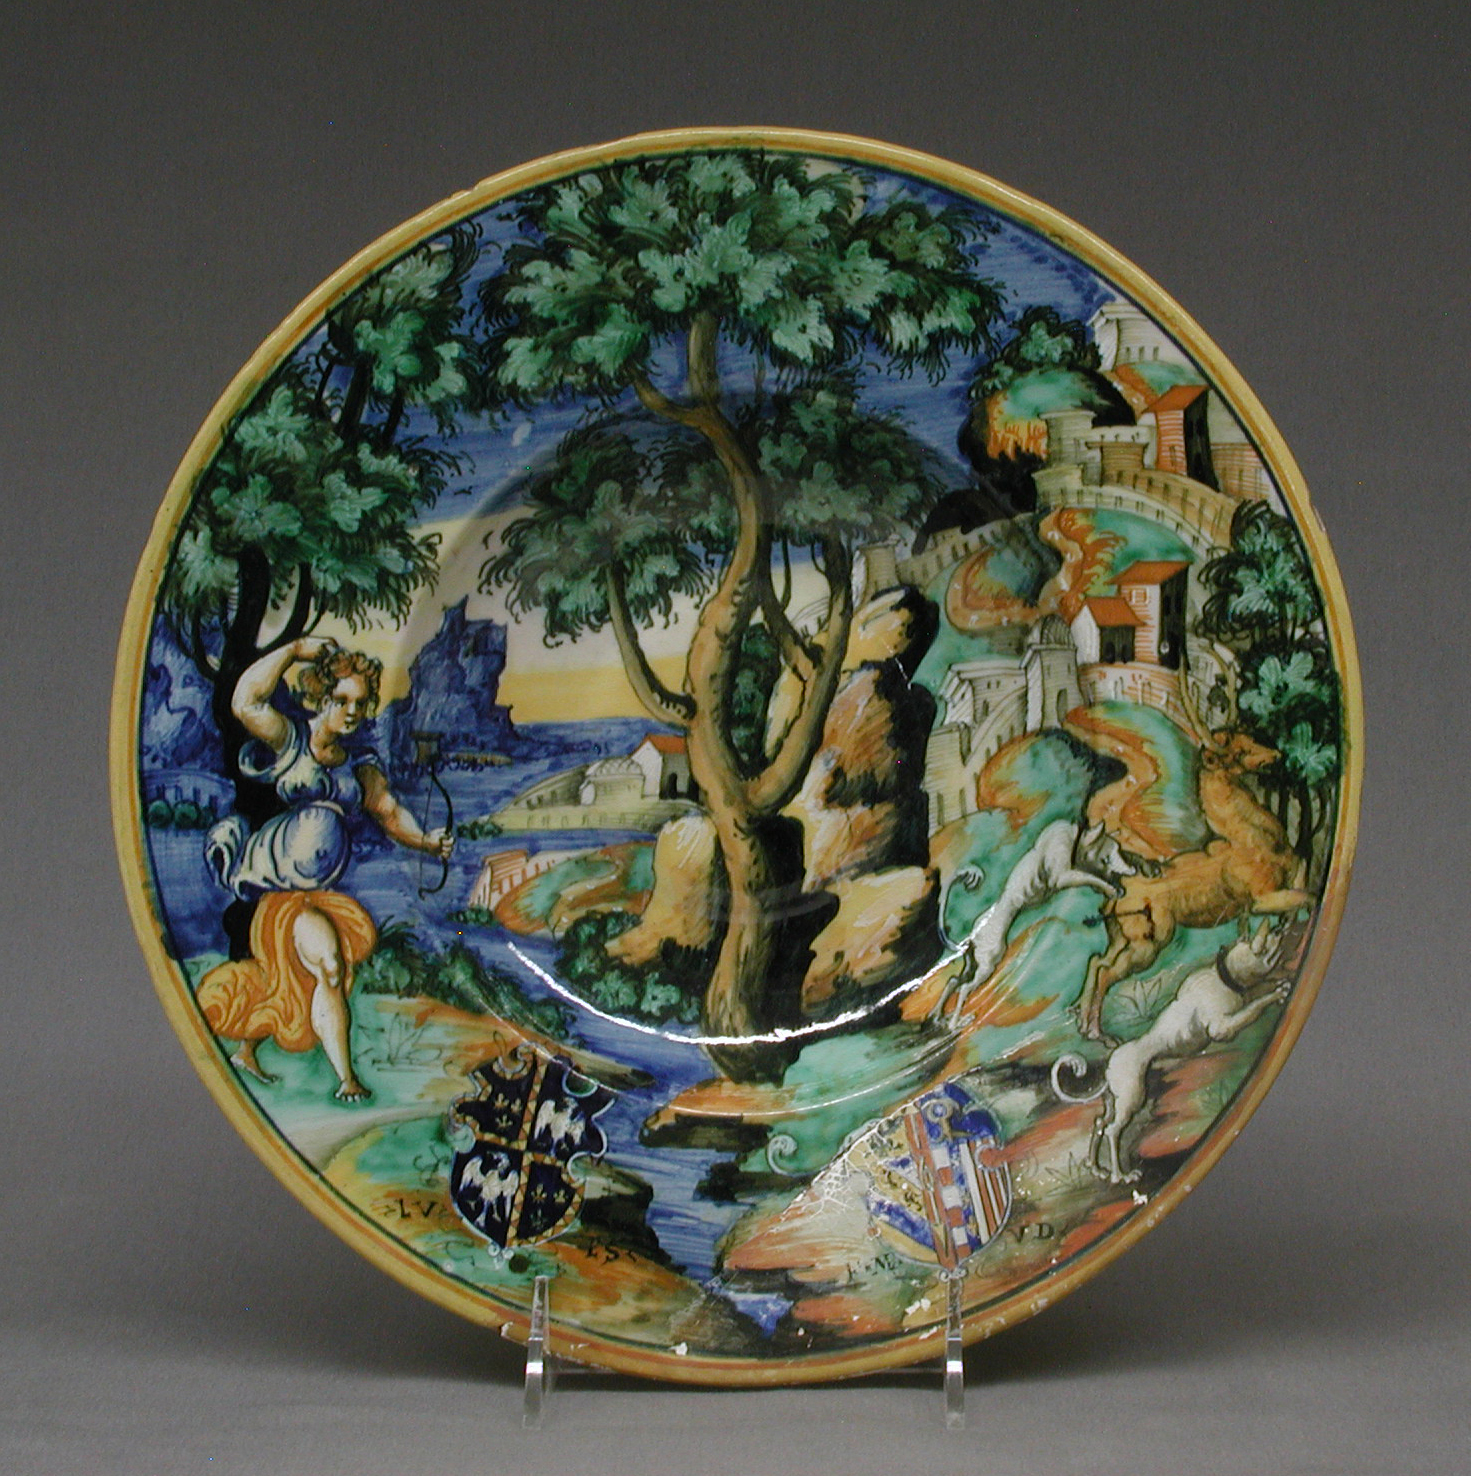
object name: plate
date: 1570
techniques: maiolica, glazing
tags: women,hunting,deer,dogs,coat of arms